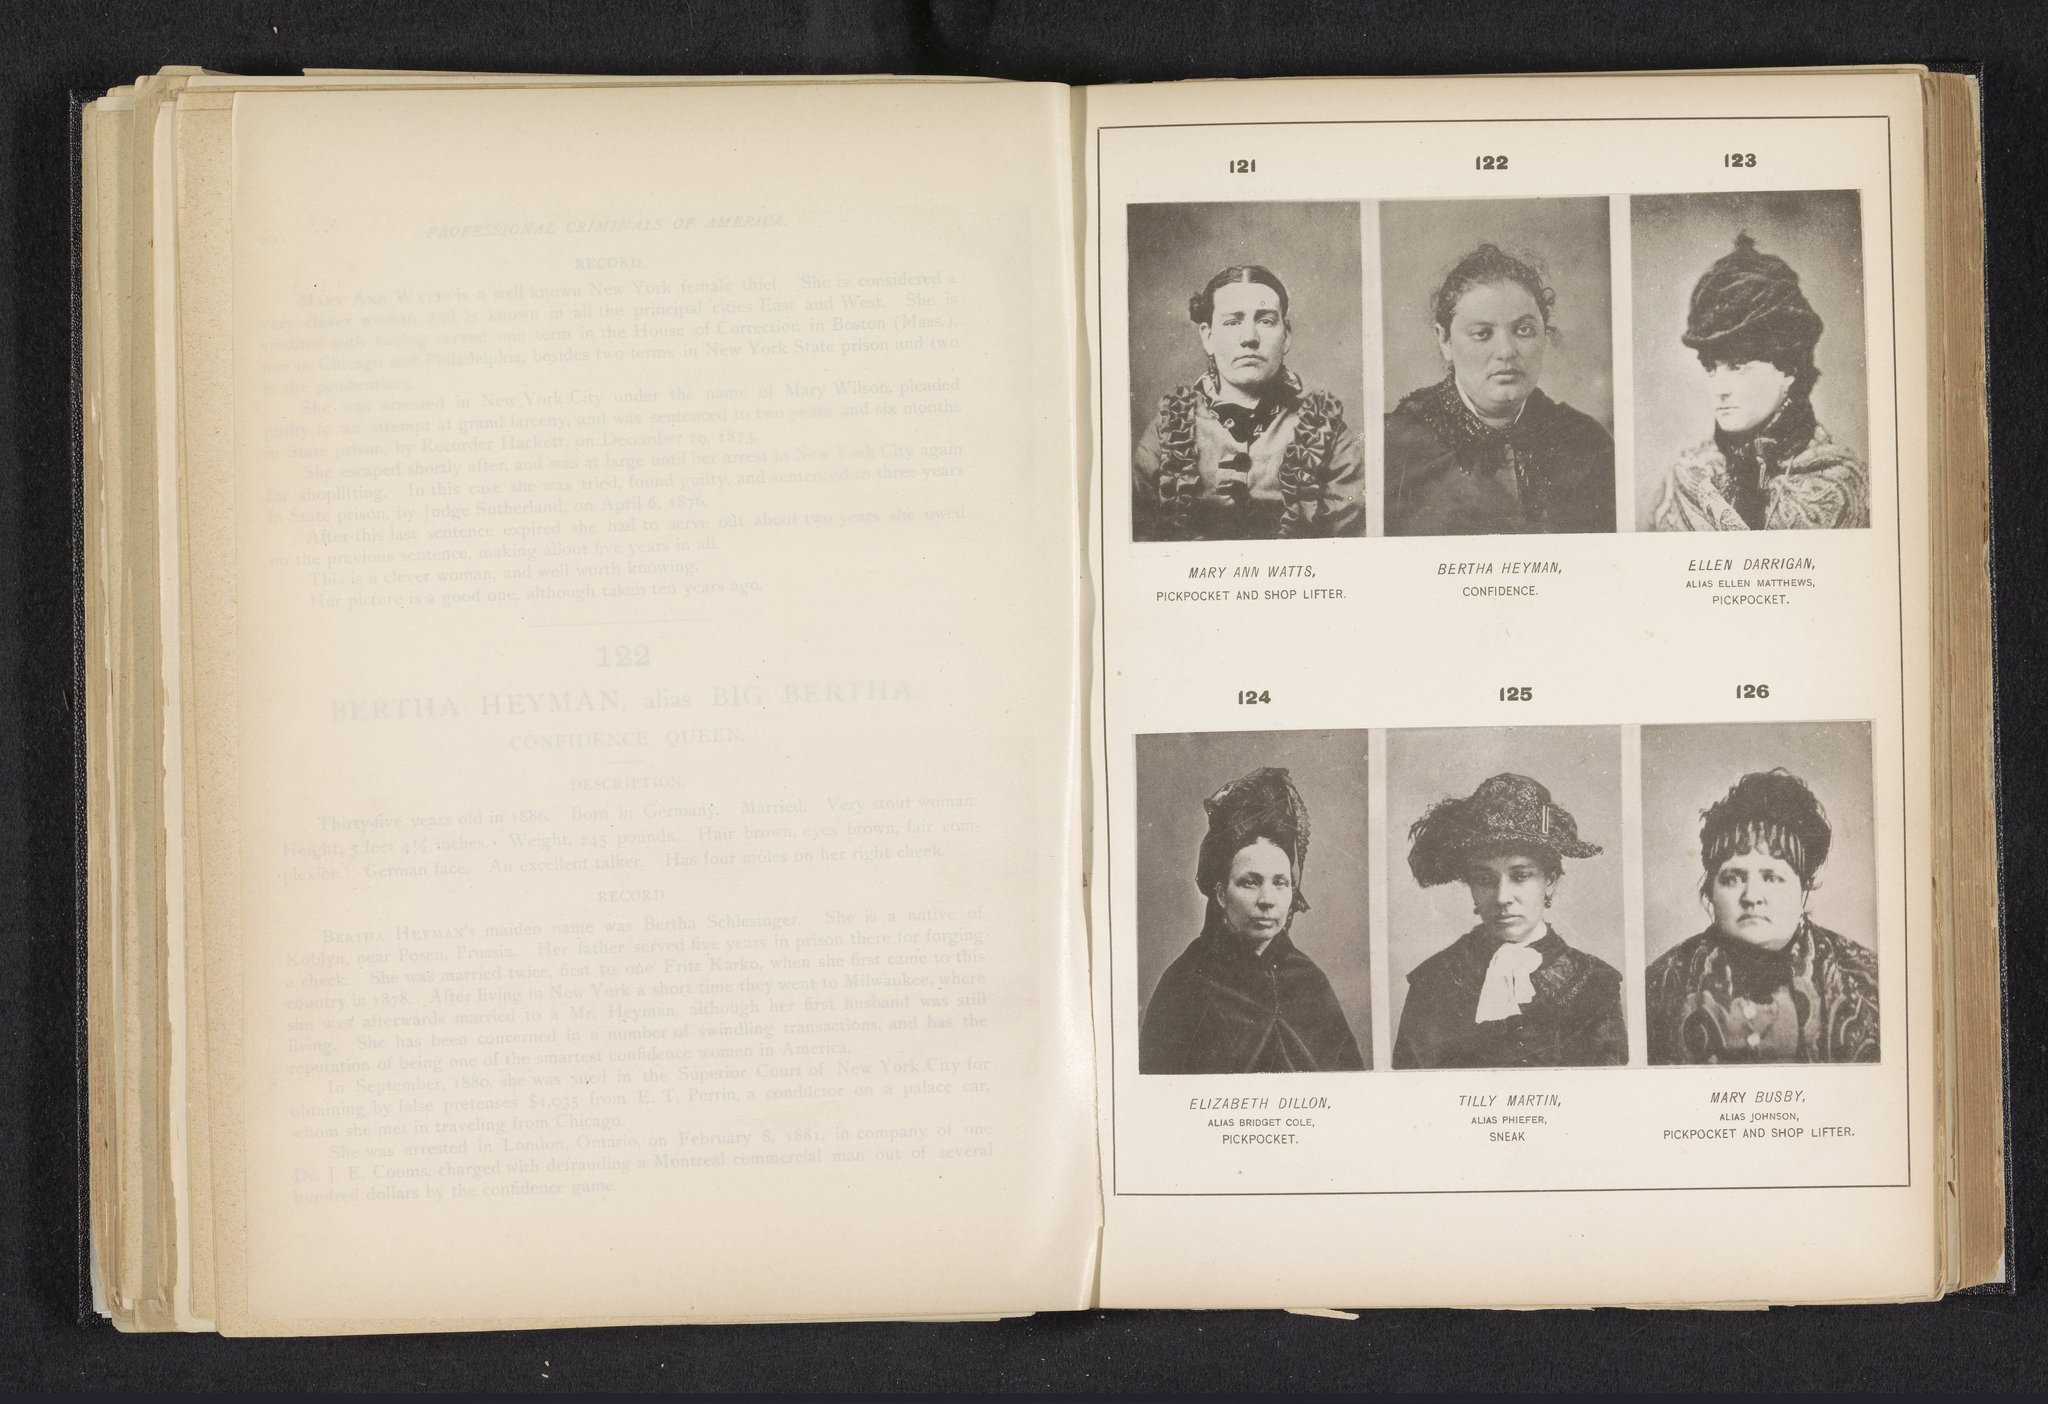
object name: page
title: Zes portretten van vrouwelijke zakkenrollers en oplichters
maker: Anonymous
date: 1881-1886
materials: paper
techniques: photograph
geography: boston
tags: historical persons not known by name - bb - woman (+ (full) bust portrait), counterfeiter - gg - female, pickpocket - gg - female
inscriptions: number: ‘121 (...) 126’, inscription: ‘Mary Ann Watts (...) pickpocket and shop lifter.’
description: Linksboven Mary Ann Watts, midden boven Bertha Heyman, rechtsboven Ellen Darrigan, linksonder Elizabeth Dillon, midden onder Tilly Martin, rechtsonder Mary Busby.